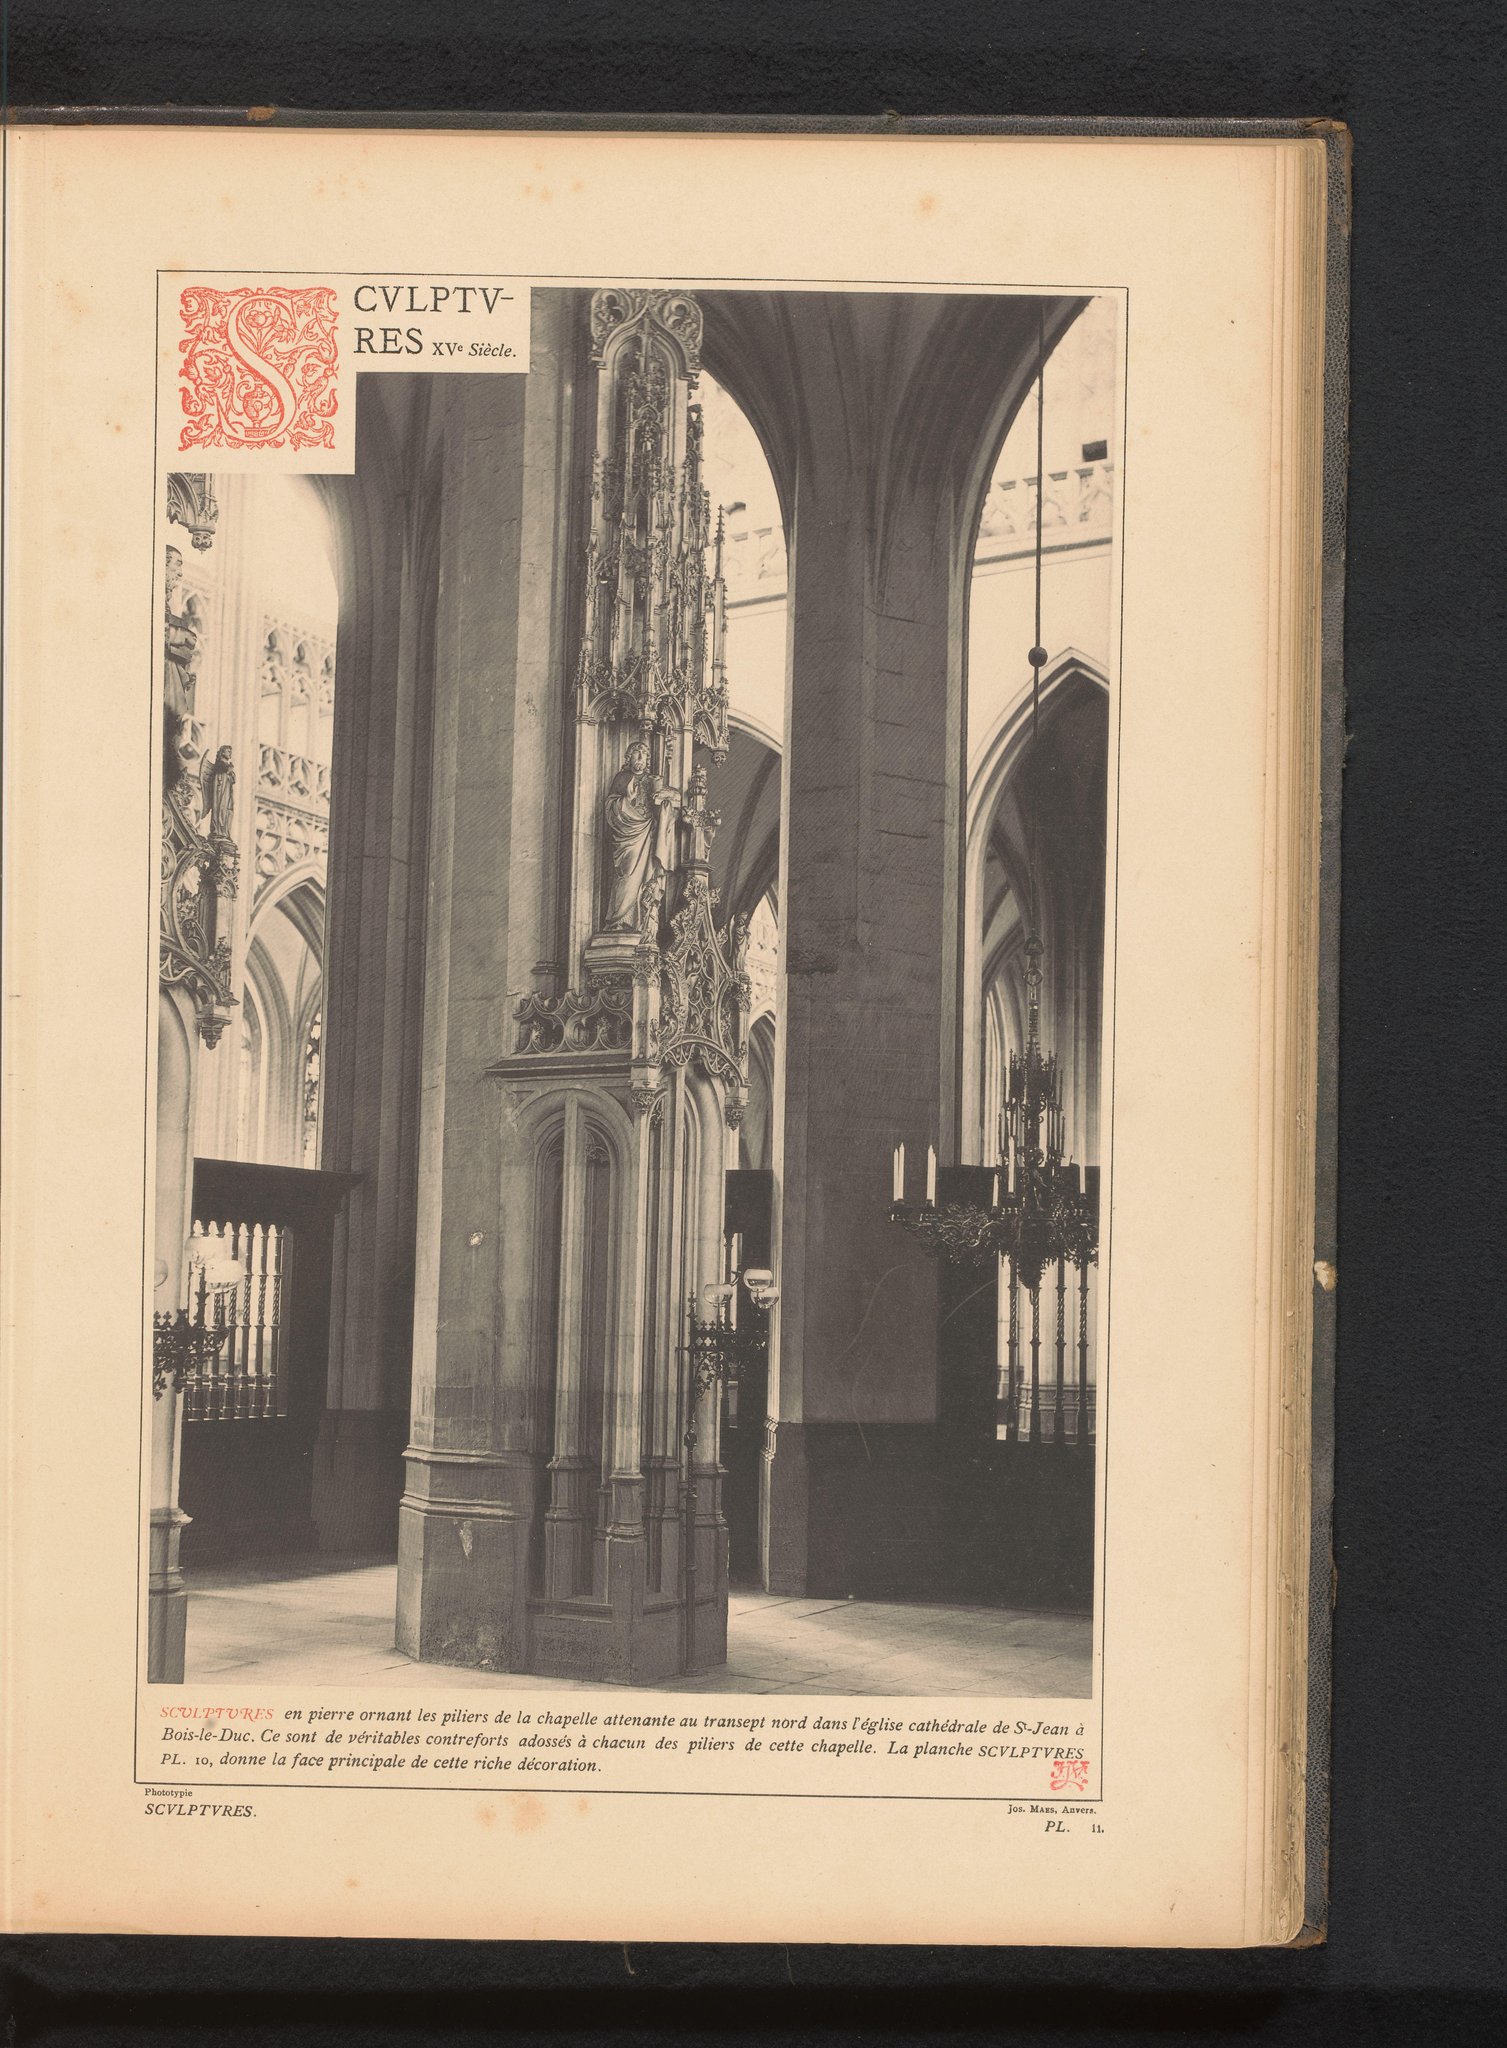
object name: page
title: Sculptures, XVe Siècle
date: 1881-1889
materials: paper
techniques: photograph, photolithography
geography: antwerp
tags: interior of church, sculpture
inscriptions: monogram: ‘JJvY’, inscription: ‘SCULPTURES en pierre (...)’, inscription: ‘SCULPTURES. PL. 11.’